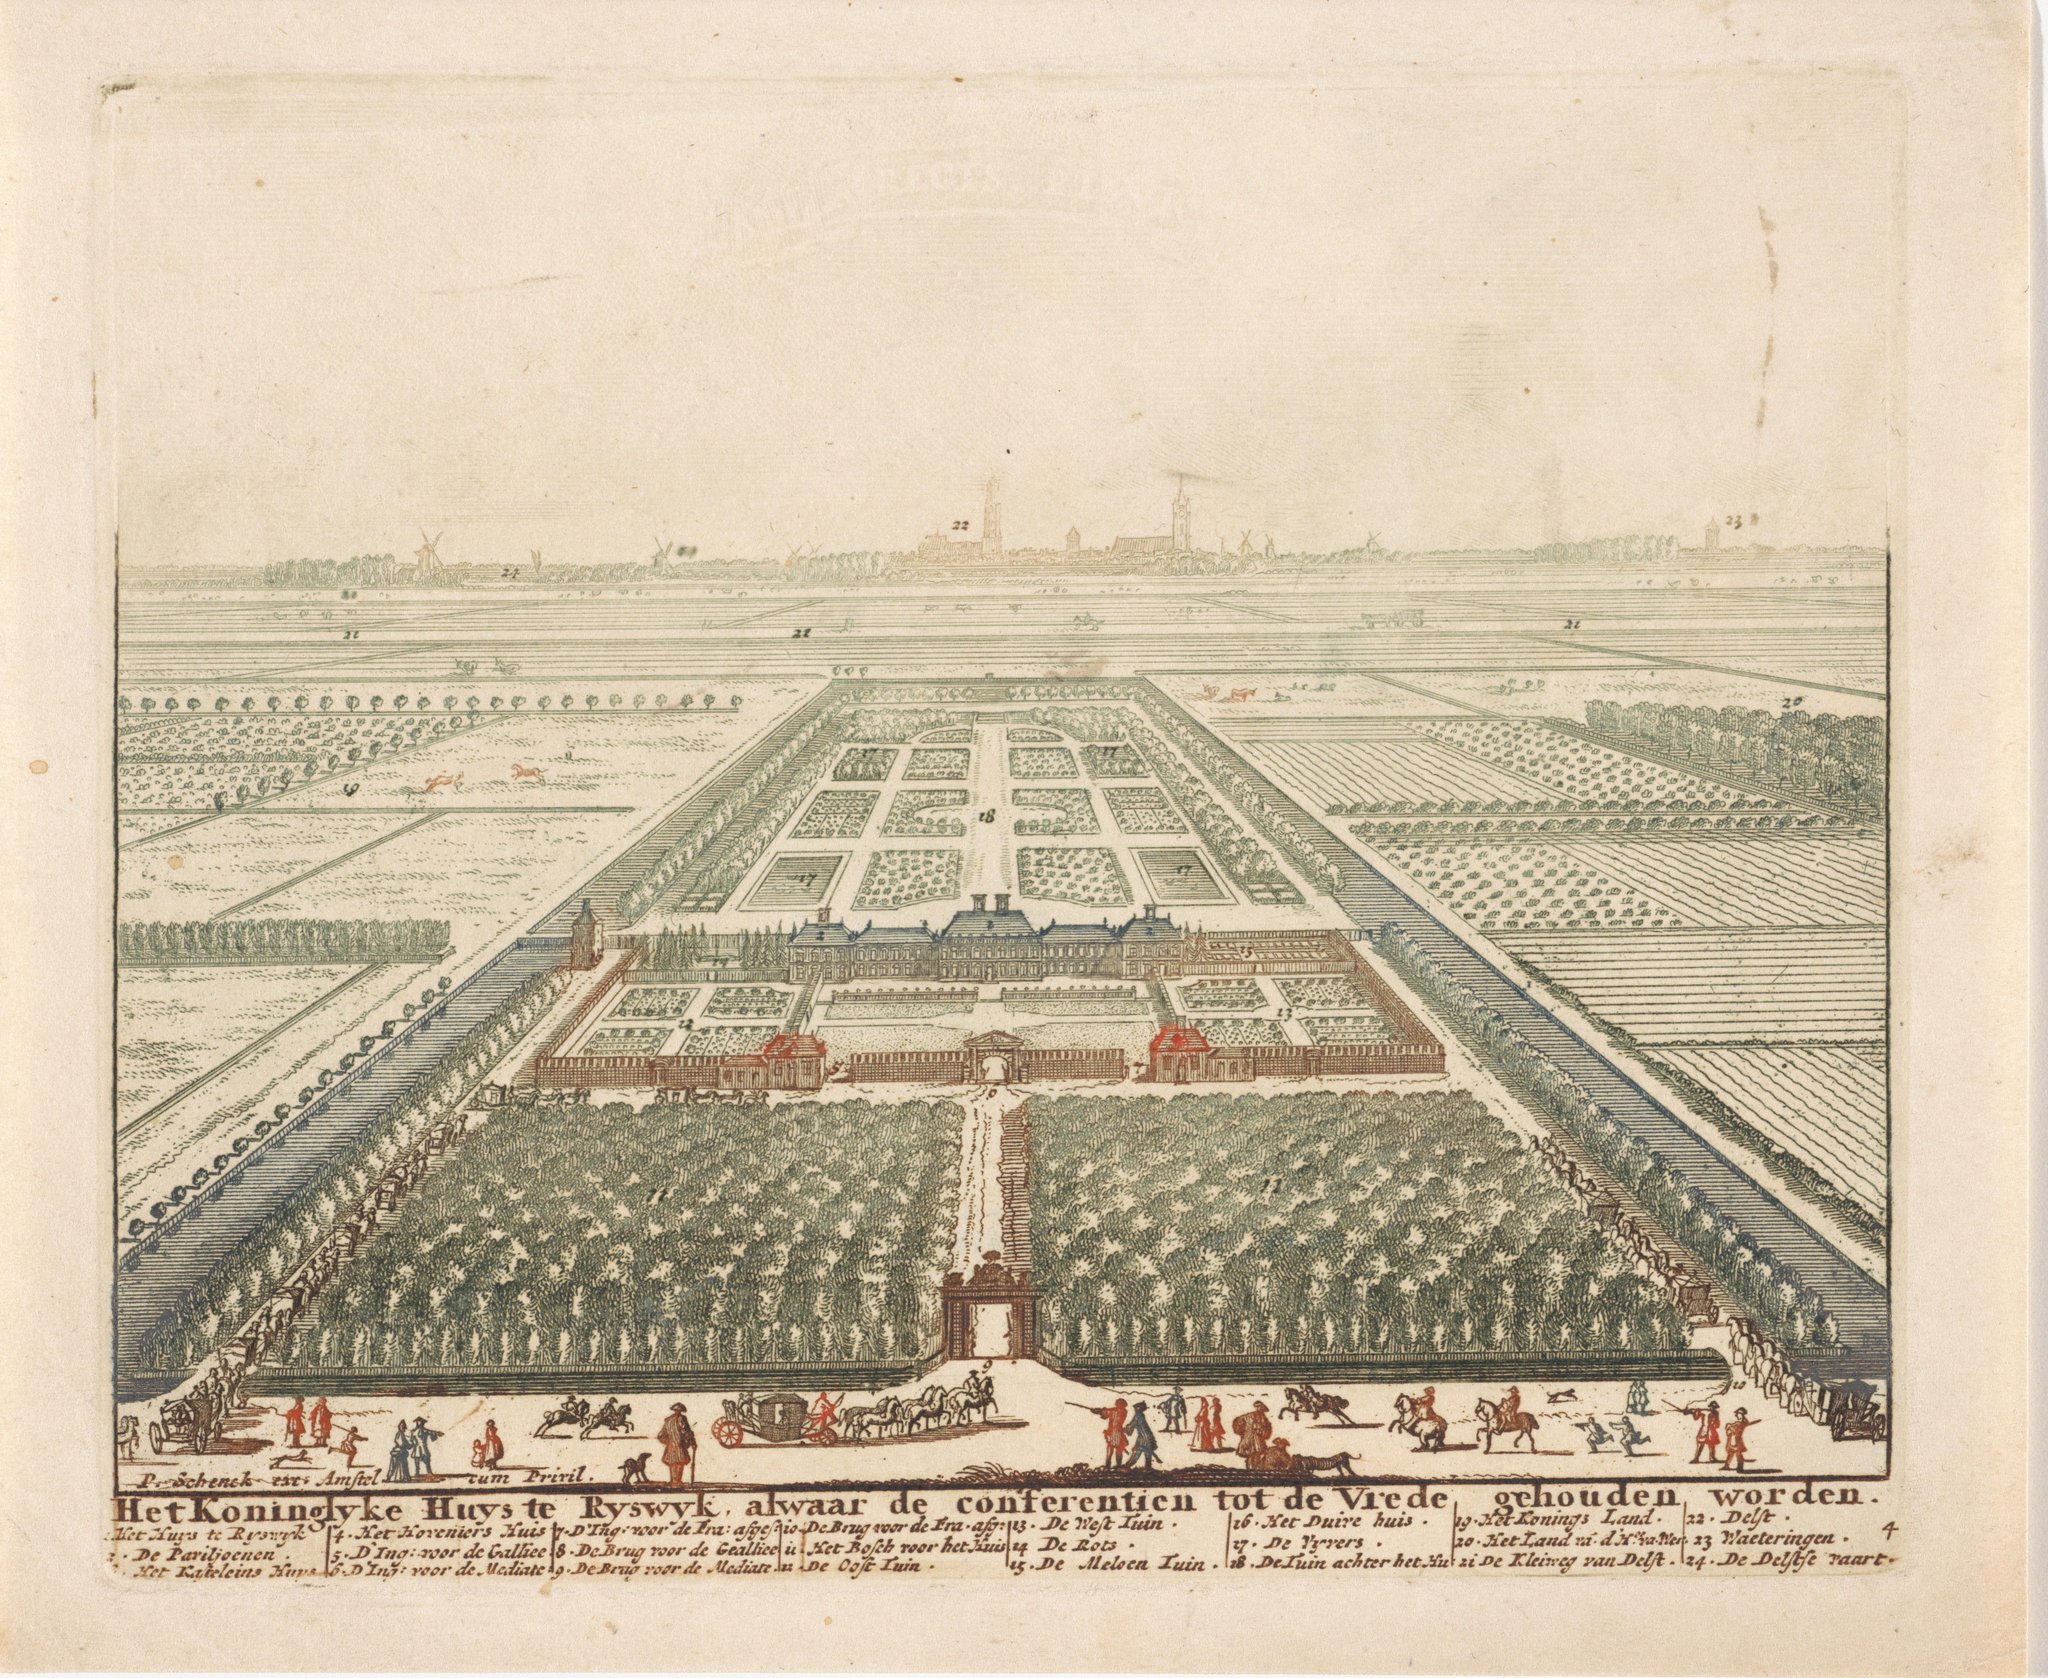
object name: print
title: Het koninglyke huys te Ryswyk, alwaar de conferentien tot de vrede gehouden worden / Villa regis, Risvicana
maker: pieter schenk (i)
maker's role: print maker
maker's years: 1660-1711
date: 1697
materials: paper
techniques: etching, lithography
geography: amsterdam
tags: palace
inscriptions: collector's mark: Lugt 2228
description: Gezicht in vogelvluchtperspectief op het Huis ter Nieuburch met de tuinen te Rijswijk. Op de voorgrond de weg uit Den Haag met de drie bruggen en de drie aparte ingangen tot het paleis, in het verschiet Delft.